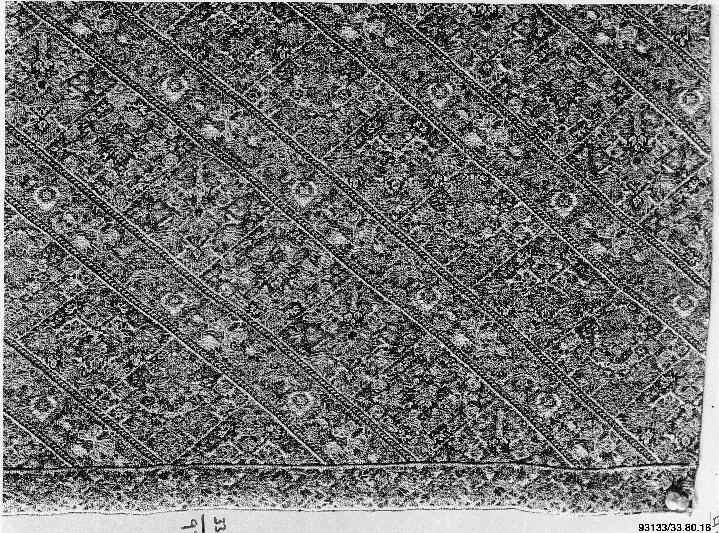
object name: trousering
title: Woman's Trousering (Nakshe)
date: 1701-1800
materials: cotton, silk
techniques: embroidery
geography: iran